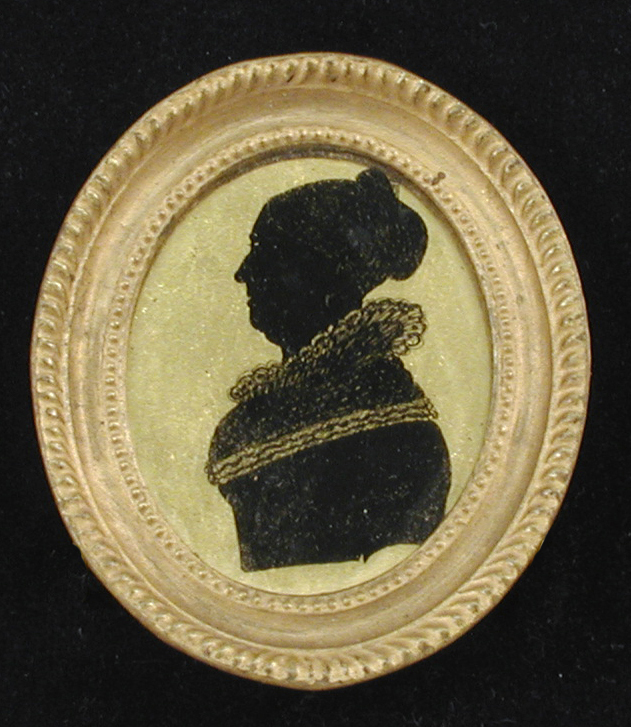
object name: medallion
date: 1801-1900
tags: profiles,women